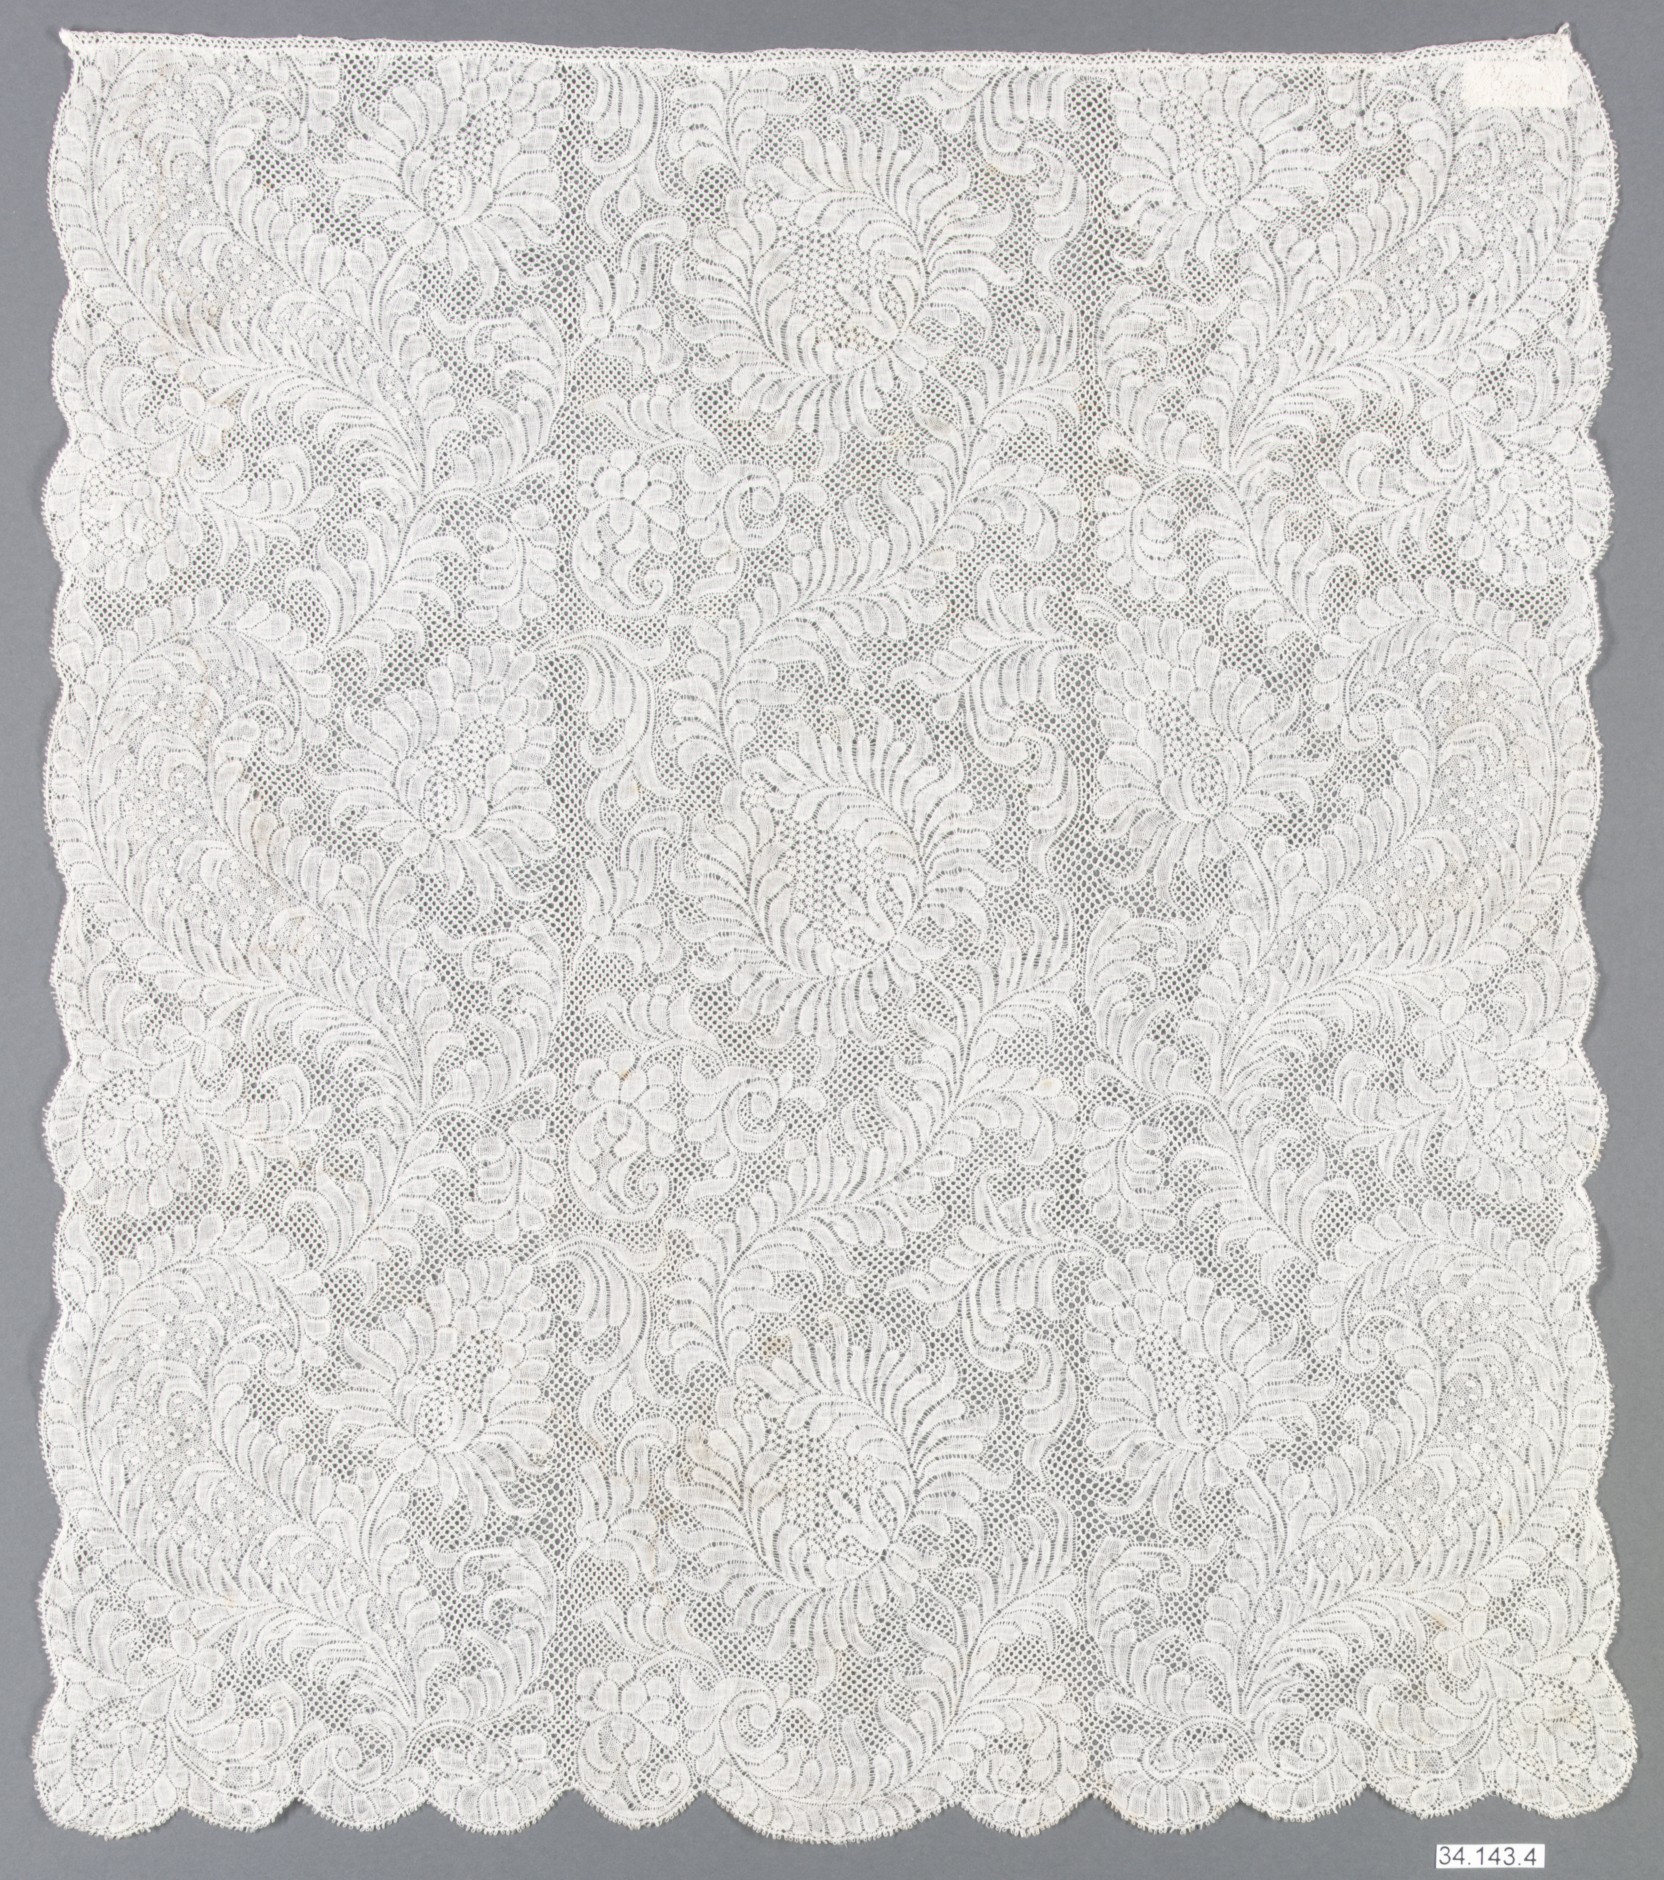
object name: cravat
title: Cravat (one of a pair)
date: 1701-1800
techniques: lace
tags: flowers